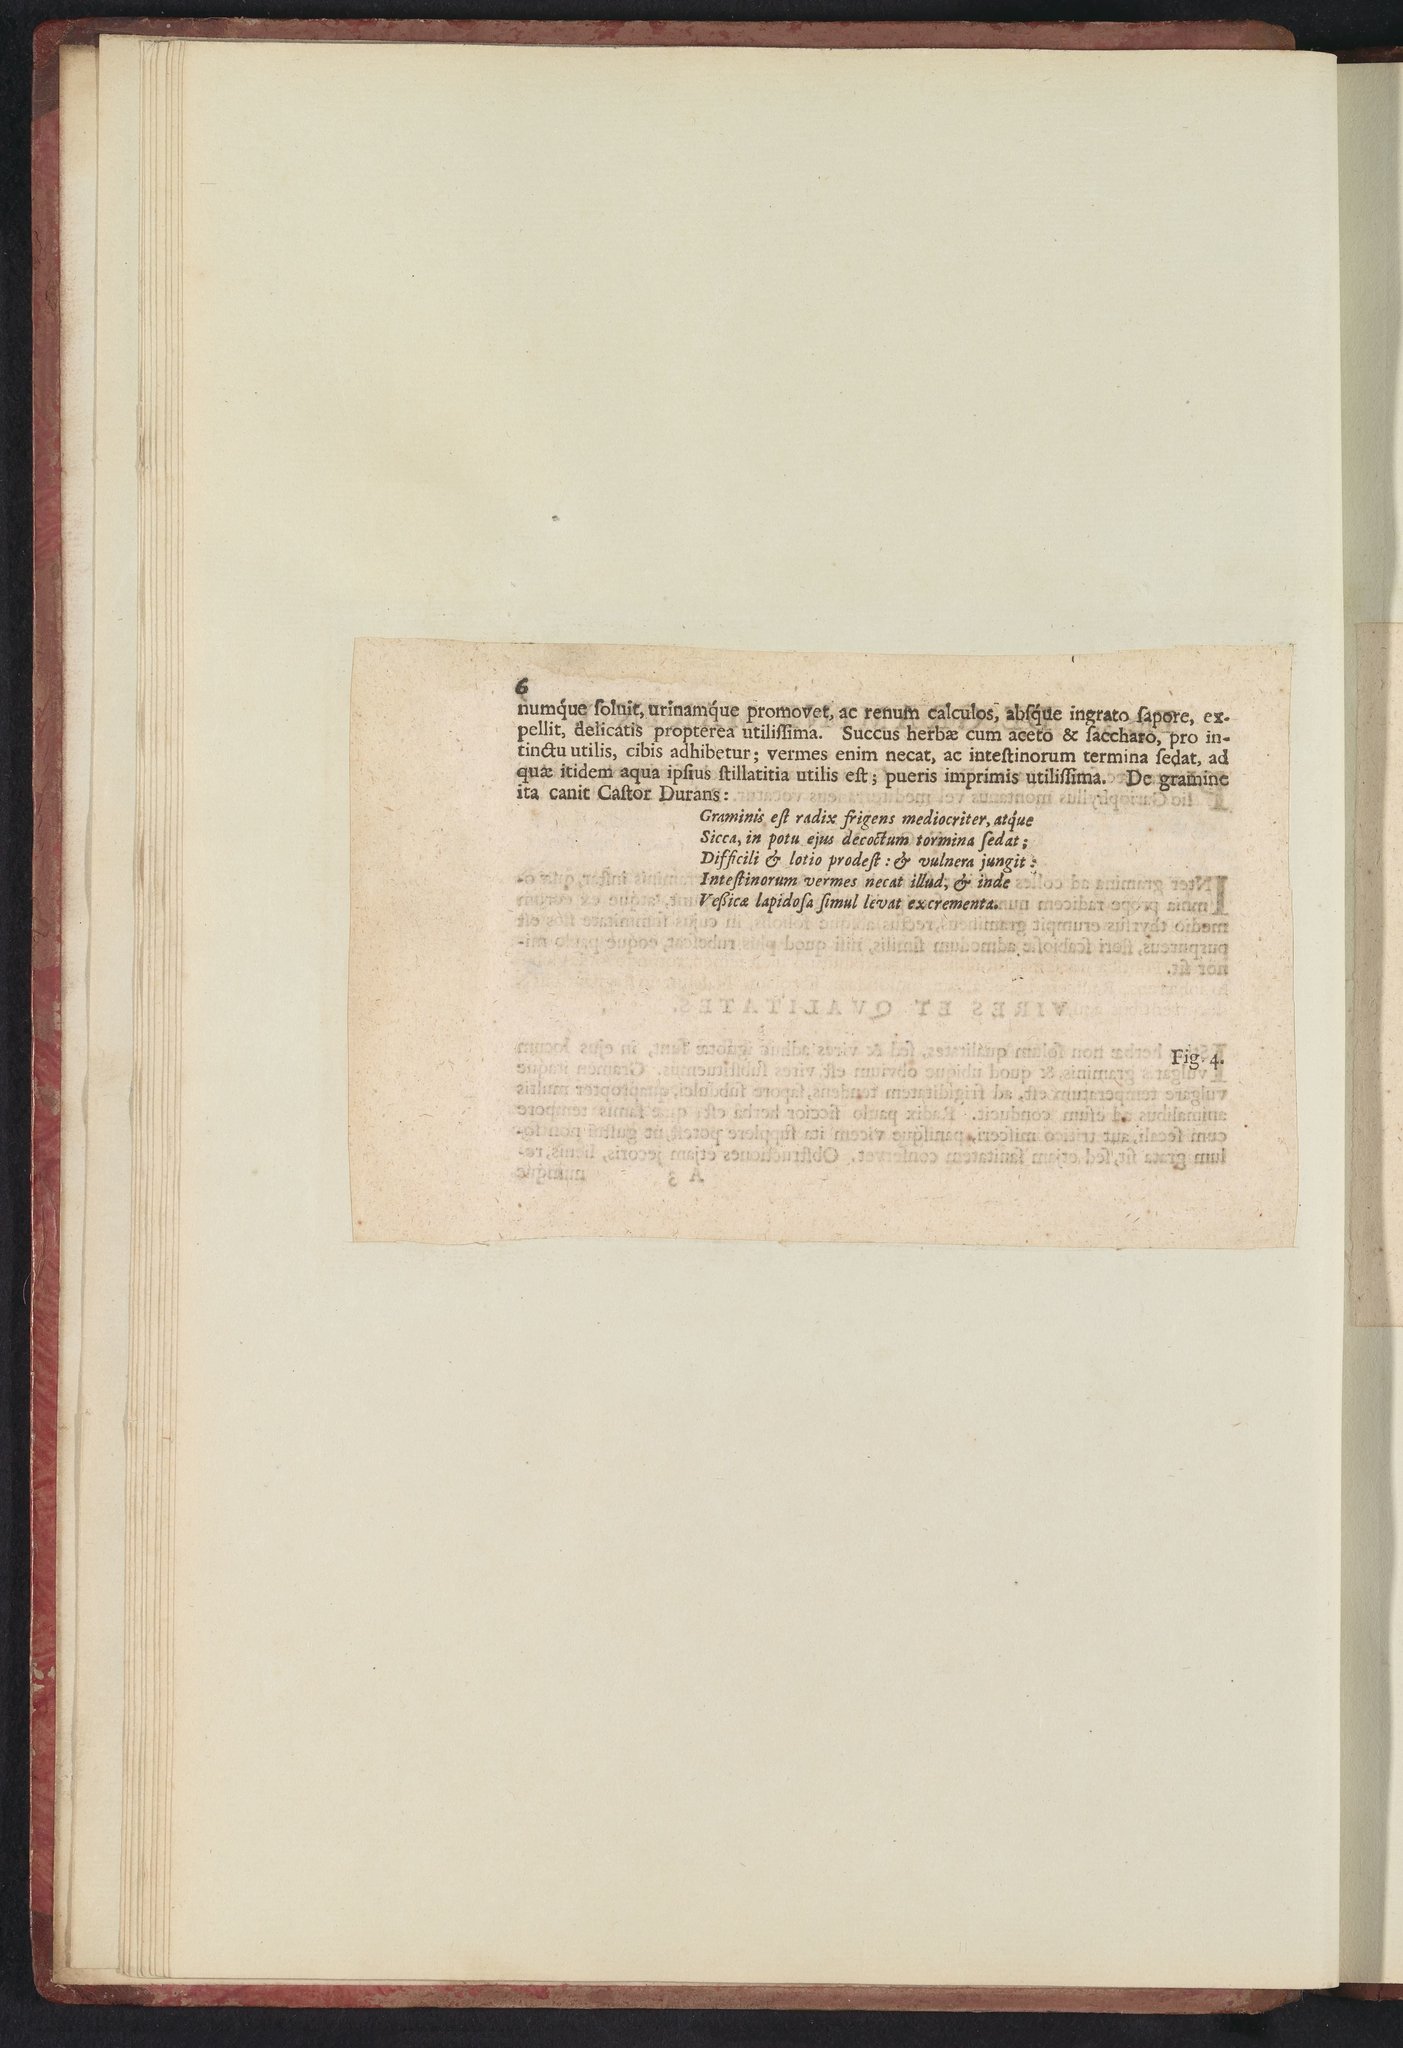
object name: text sheet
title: Fig. 3 'De Gramine Marino' in De Boodts herbarium van 1640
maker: anselmus boëtius de boodt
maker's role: draughtsman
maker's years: 1550-1632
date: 1640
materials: ink, paper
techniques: letterpress printing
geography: bruges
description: Beschrijving bij Fig. 3 op p. 6 in: Anselmi Boëtii de Boot I.C. Brugensis & Rodolphi II. Imp. Roman. medici a cubiculis Florum, Herbarum, ac fructuum selectiorum icones, & vires pleraeque hactenus ignotæ. Onderdeel van het album met bladen en platen uit De Boodts herbarium van 1640. Het twaalfde van twaalf albums met aquarellen van dieren, vogels en planten bekend rond 1600, gemaakt in opdracht van keizer Rudolf II.